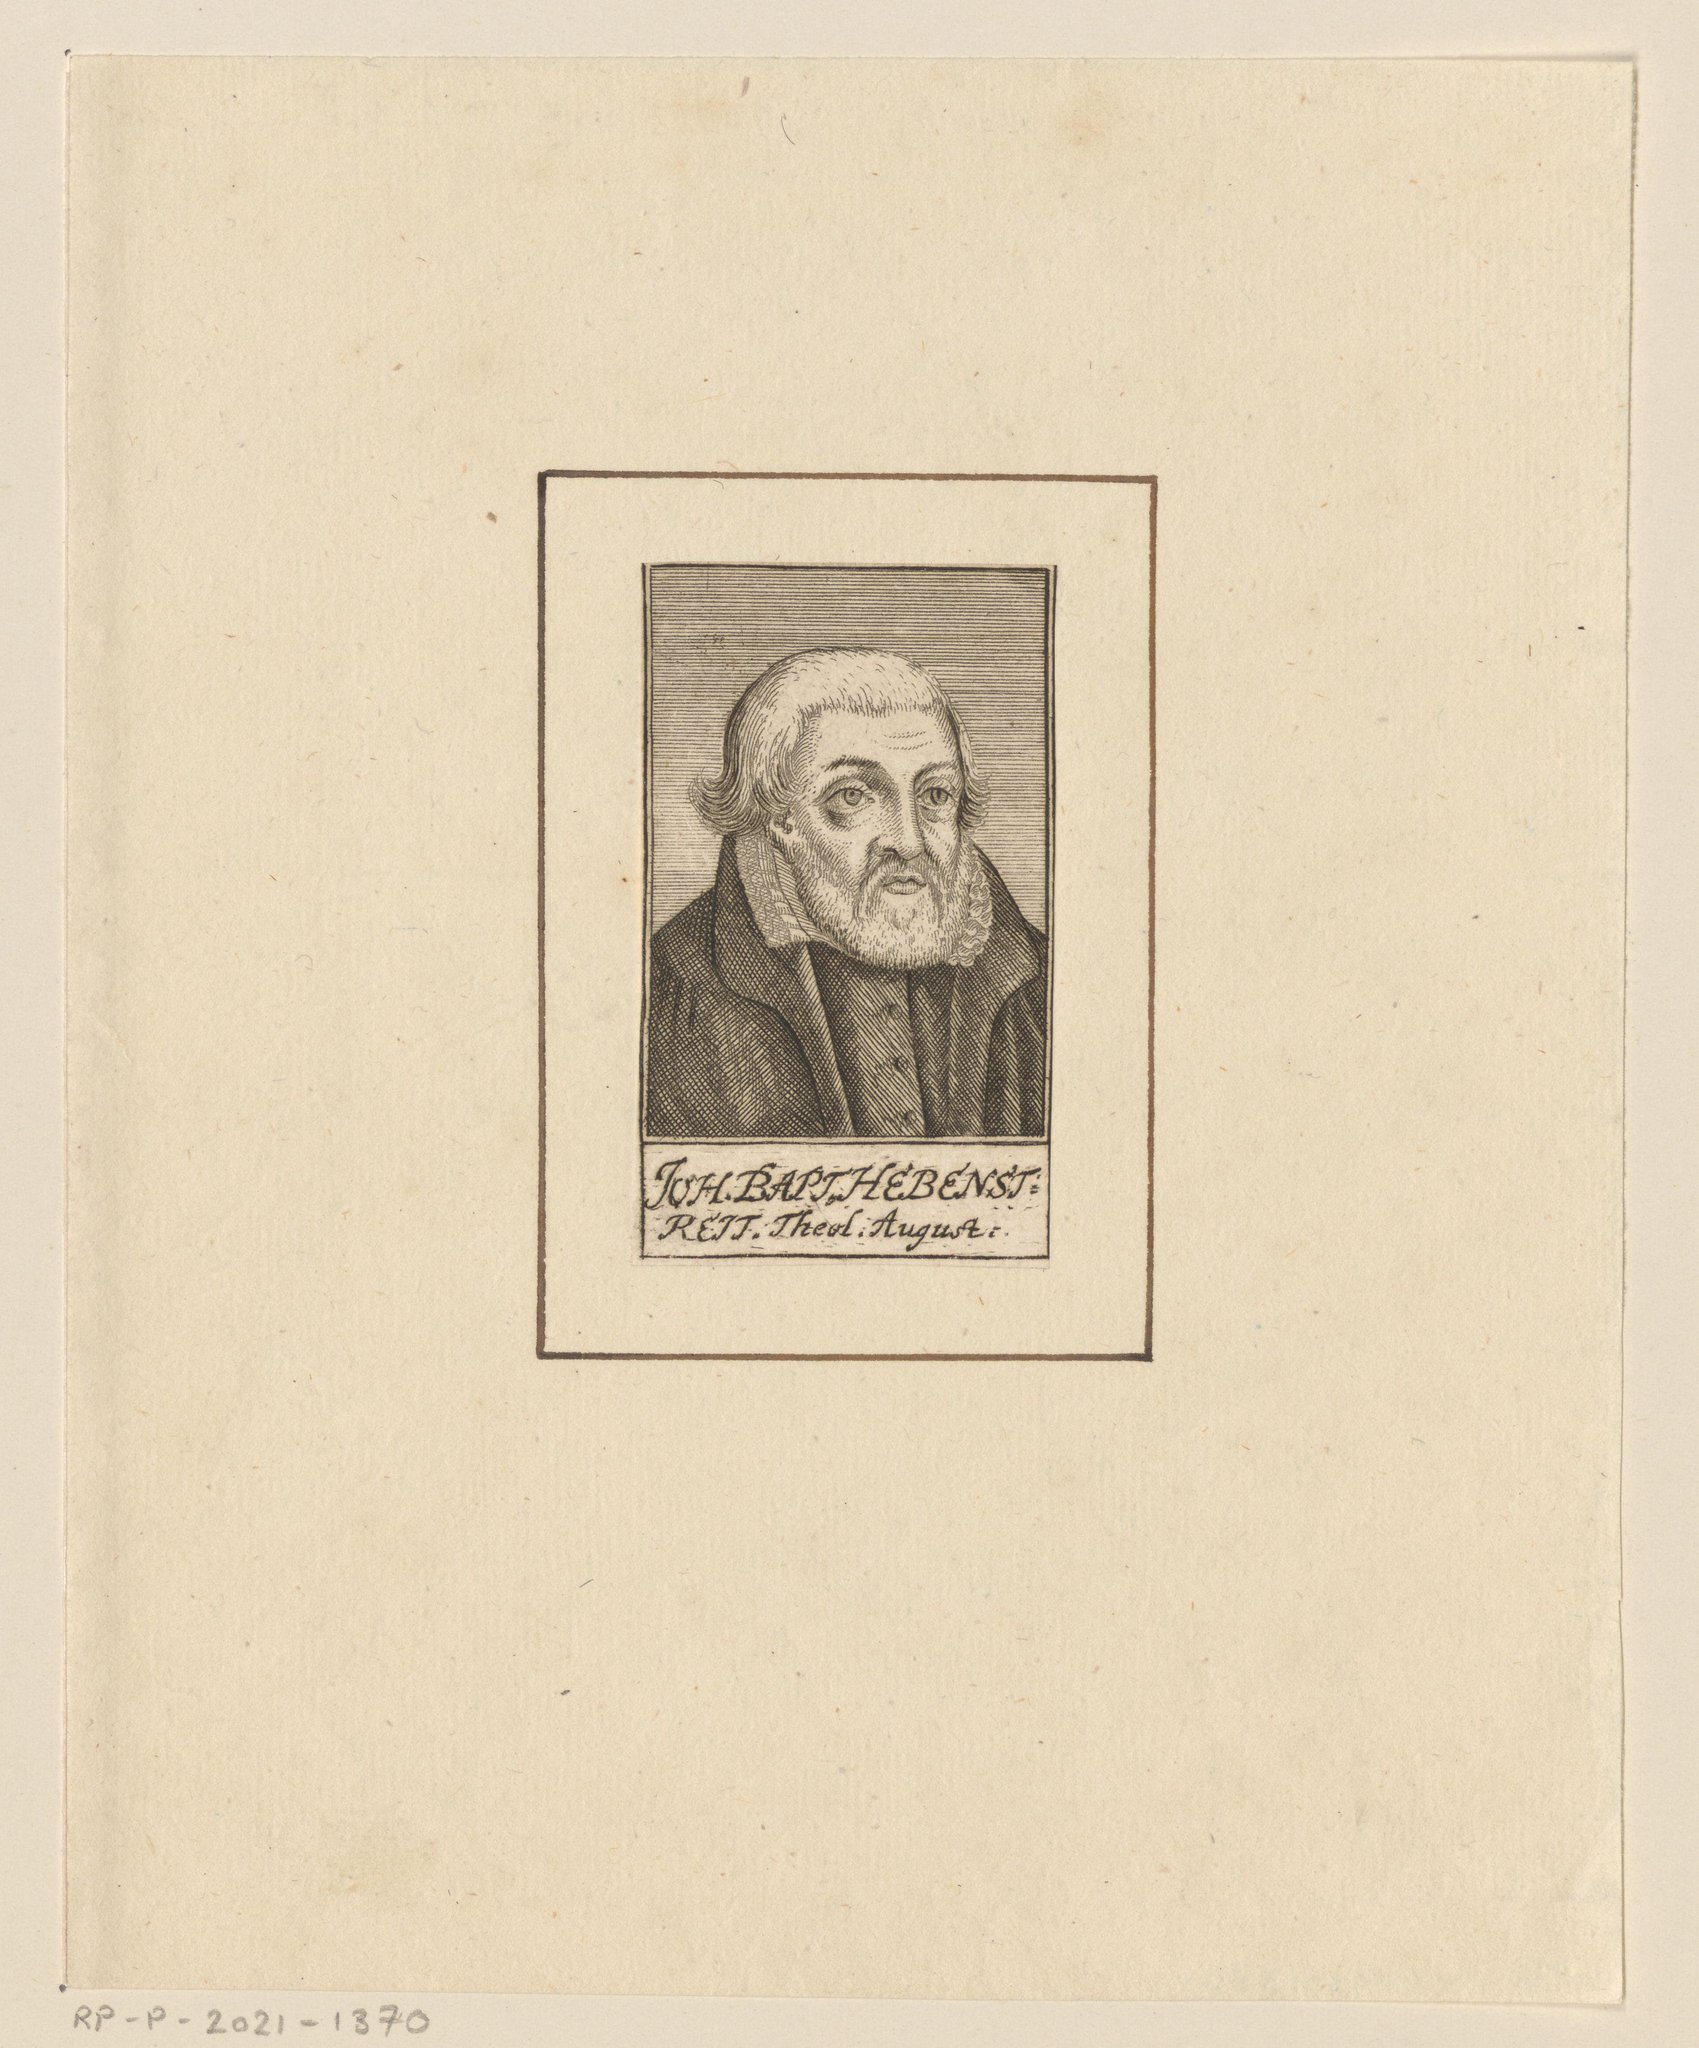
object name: print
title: Portret van Johann Baptist Hebenstreit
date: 1688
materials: paper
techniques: engraving, etching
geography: nuremberg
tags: augsburg, johann baptist hebenstreit, theologian, historical persons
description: Prent uit: Freher, Paul. Theatrum virorum eruditione clarorum. Neurenberg: Johann Hoffmann, 1688.